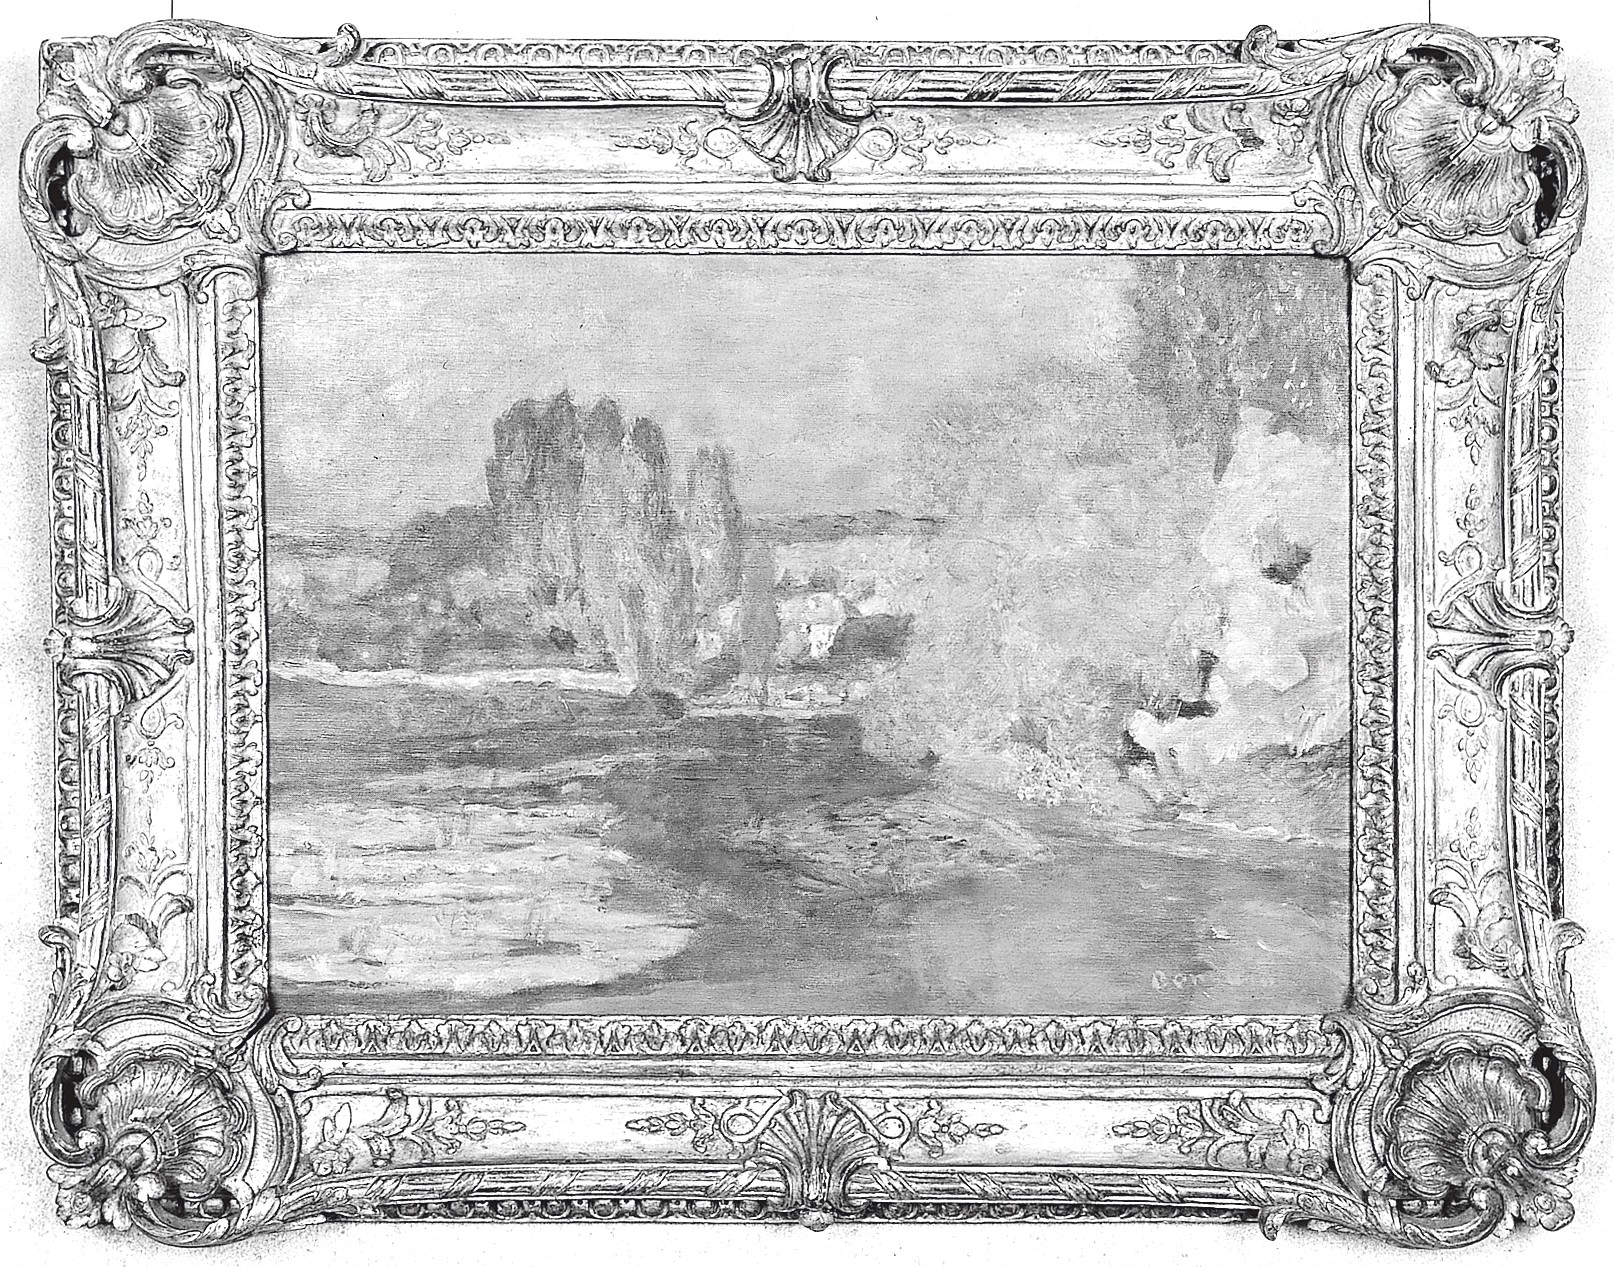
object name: frame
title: Hollow frame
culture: french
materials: feather, wood